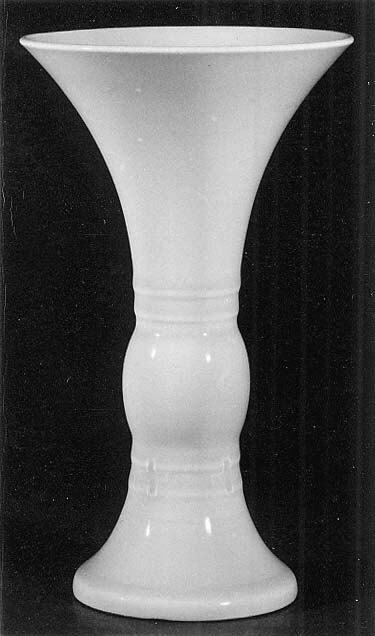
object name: vase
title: Vase in the shape of an ancient ritual beaker (gu)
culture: chinese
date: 1901-1933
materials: glaze, porcelain